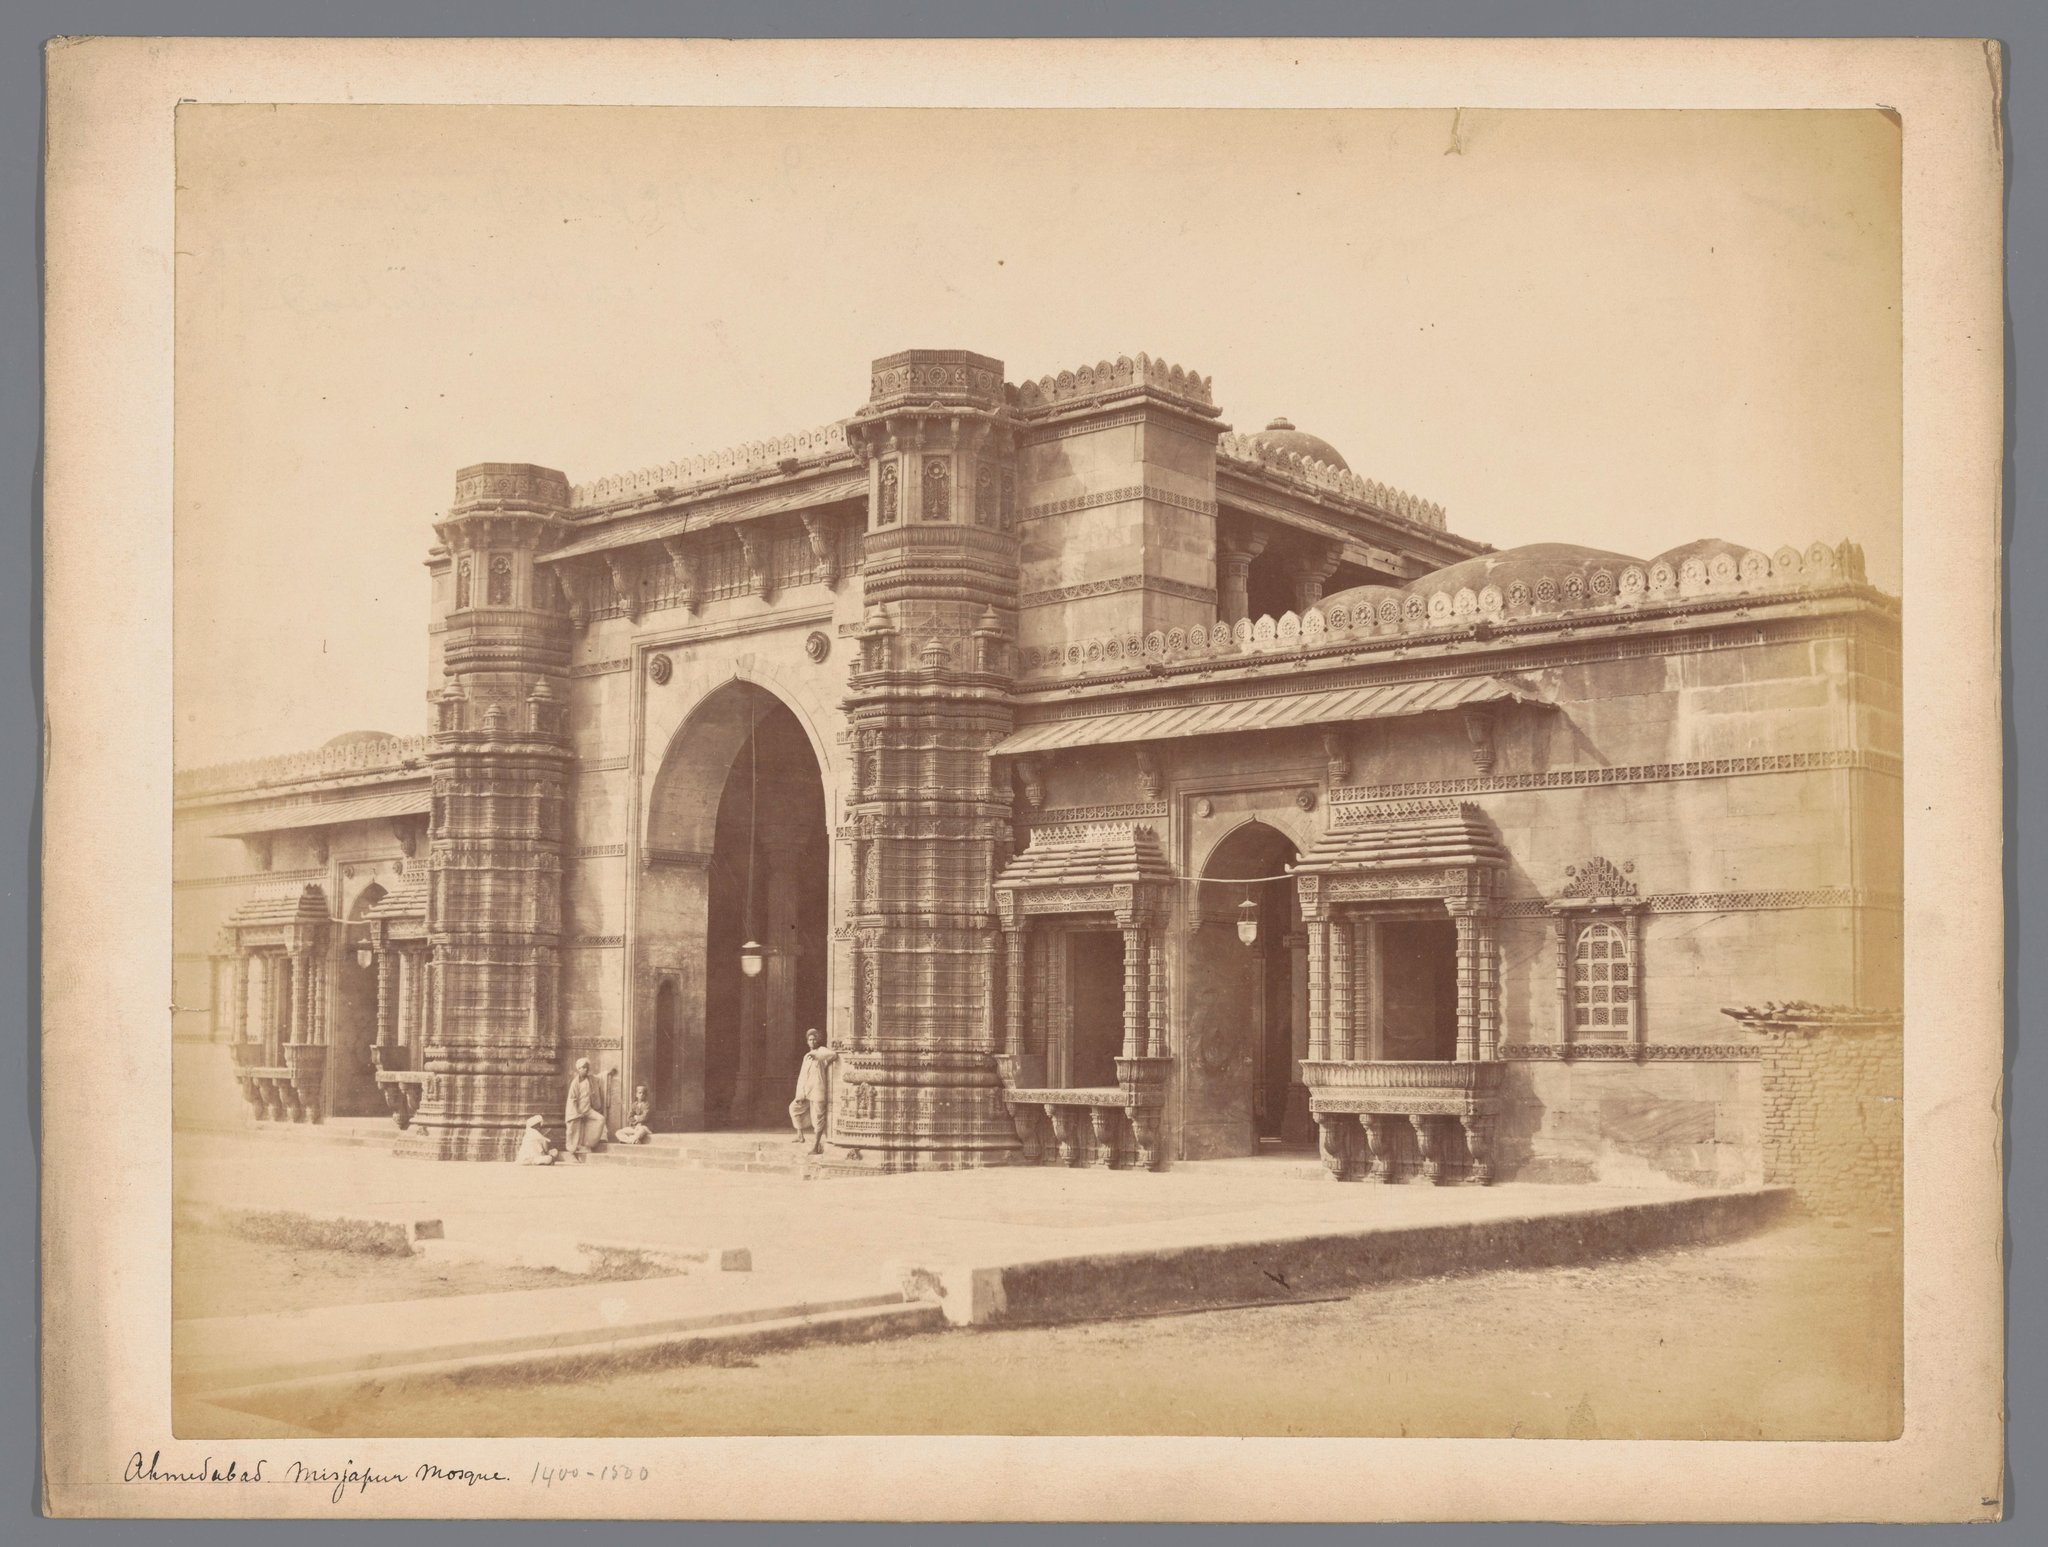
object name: photograph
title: Exterior of the Rani Rupmati mosque in Ahmedebad, Gujarat, India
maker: Anonymous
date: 1865-1890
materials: cardboard, paper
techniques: albumen print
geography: ahmedabad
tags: temple, shrine ~ islam, mohammedanism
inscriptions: title: ‘Ahmedebad. Mirjapur Mosque. 1400-1500’, number: ‘20’